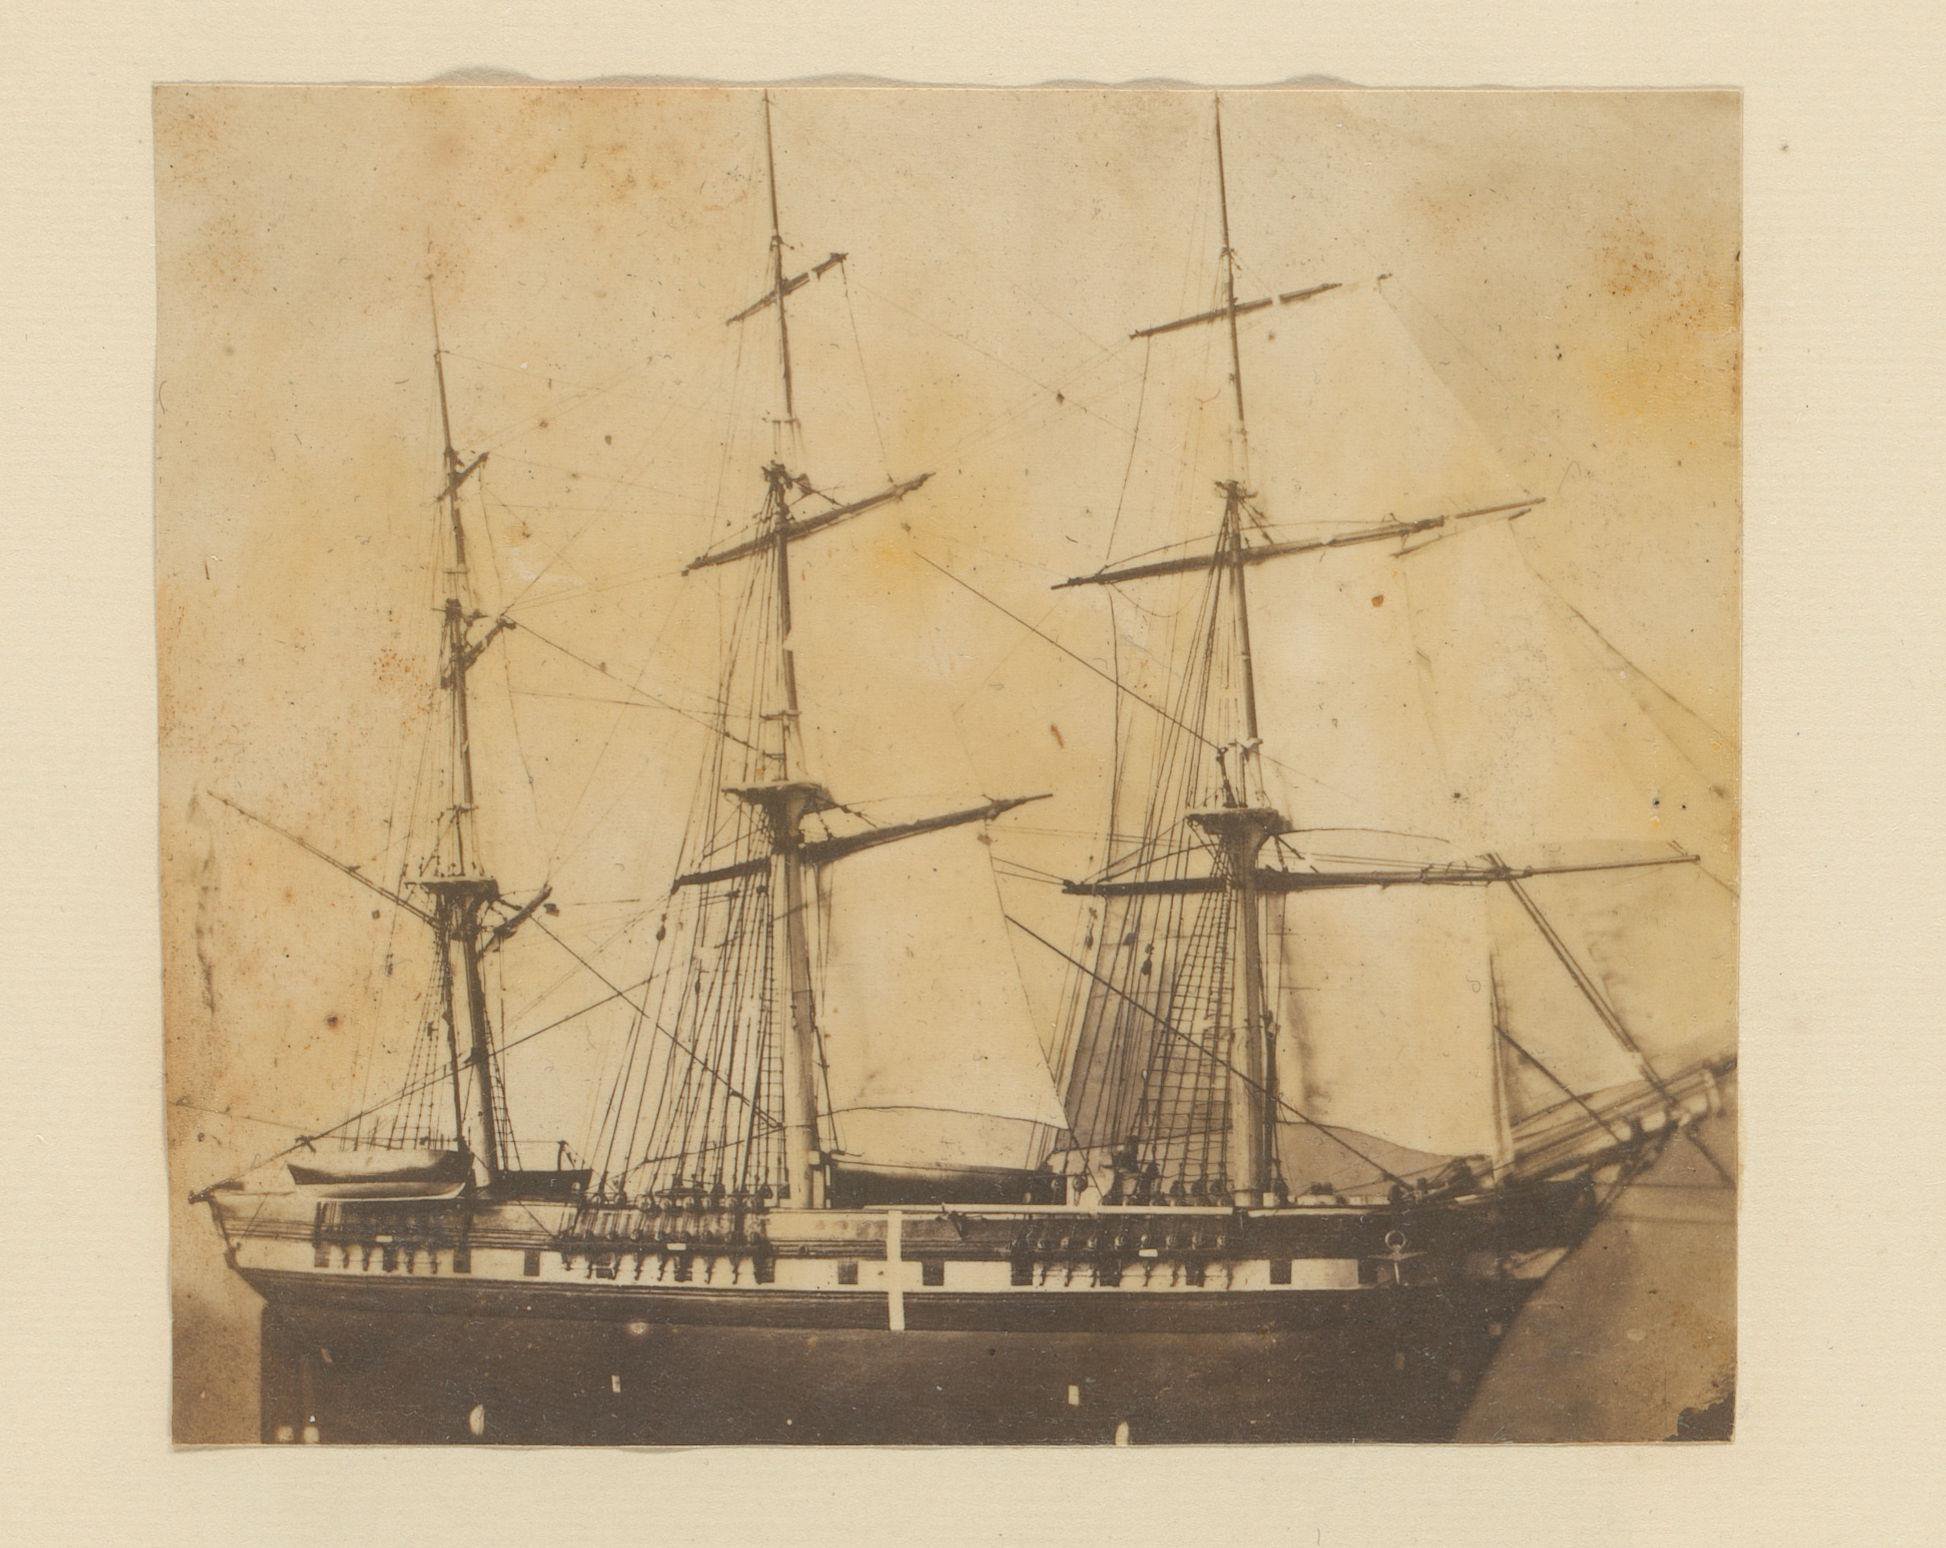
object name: photograph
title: Scheepsmodel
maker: eduard isaac asser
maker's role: amateurfotograaf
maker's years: 1809-1894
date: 1852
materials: cardboard, paper, photographic support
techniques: salted paper print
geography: amsterdam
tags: ship-model (+ propulsion of vehicle, ship, etc. by wind)